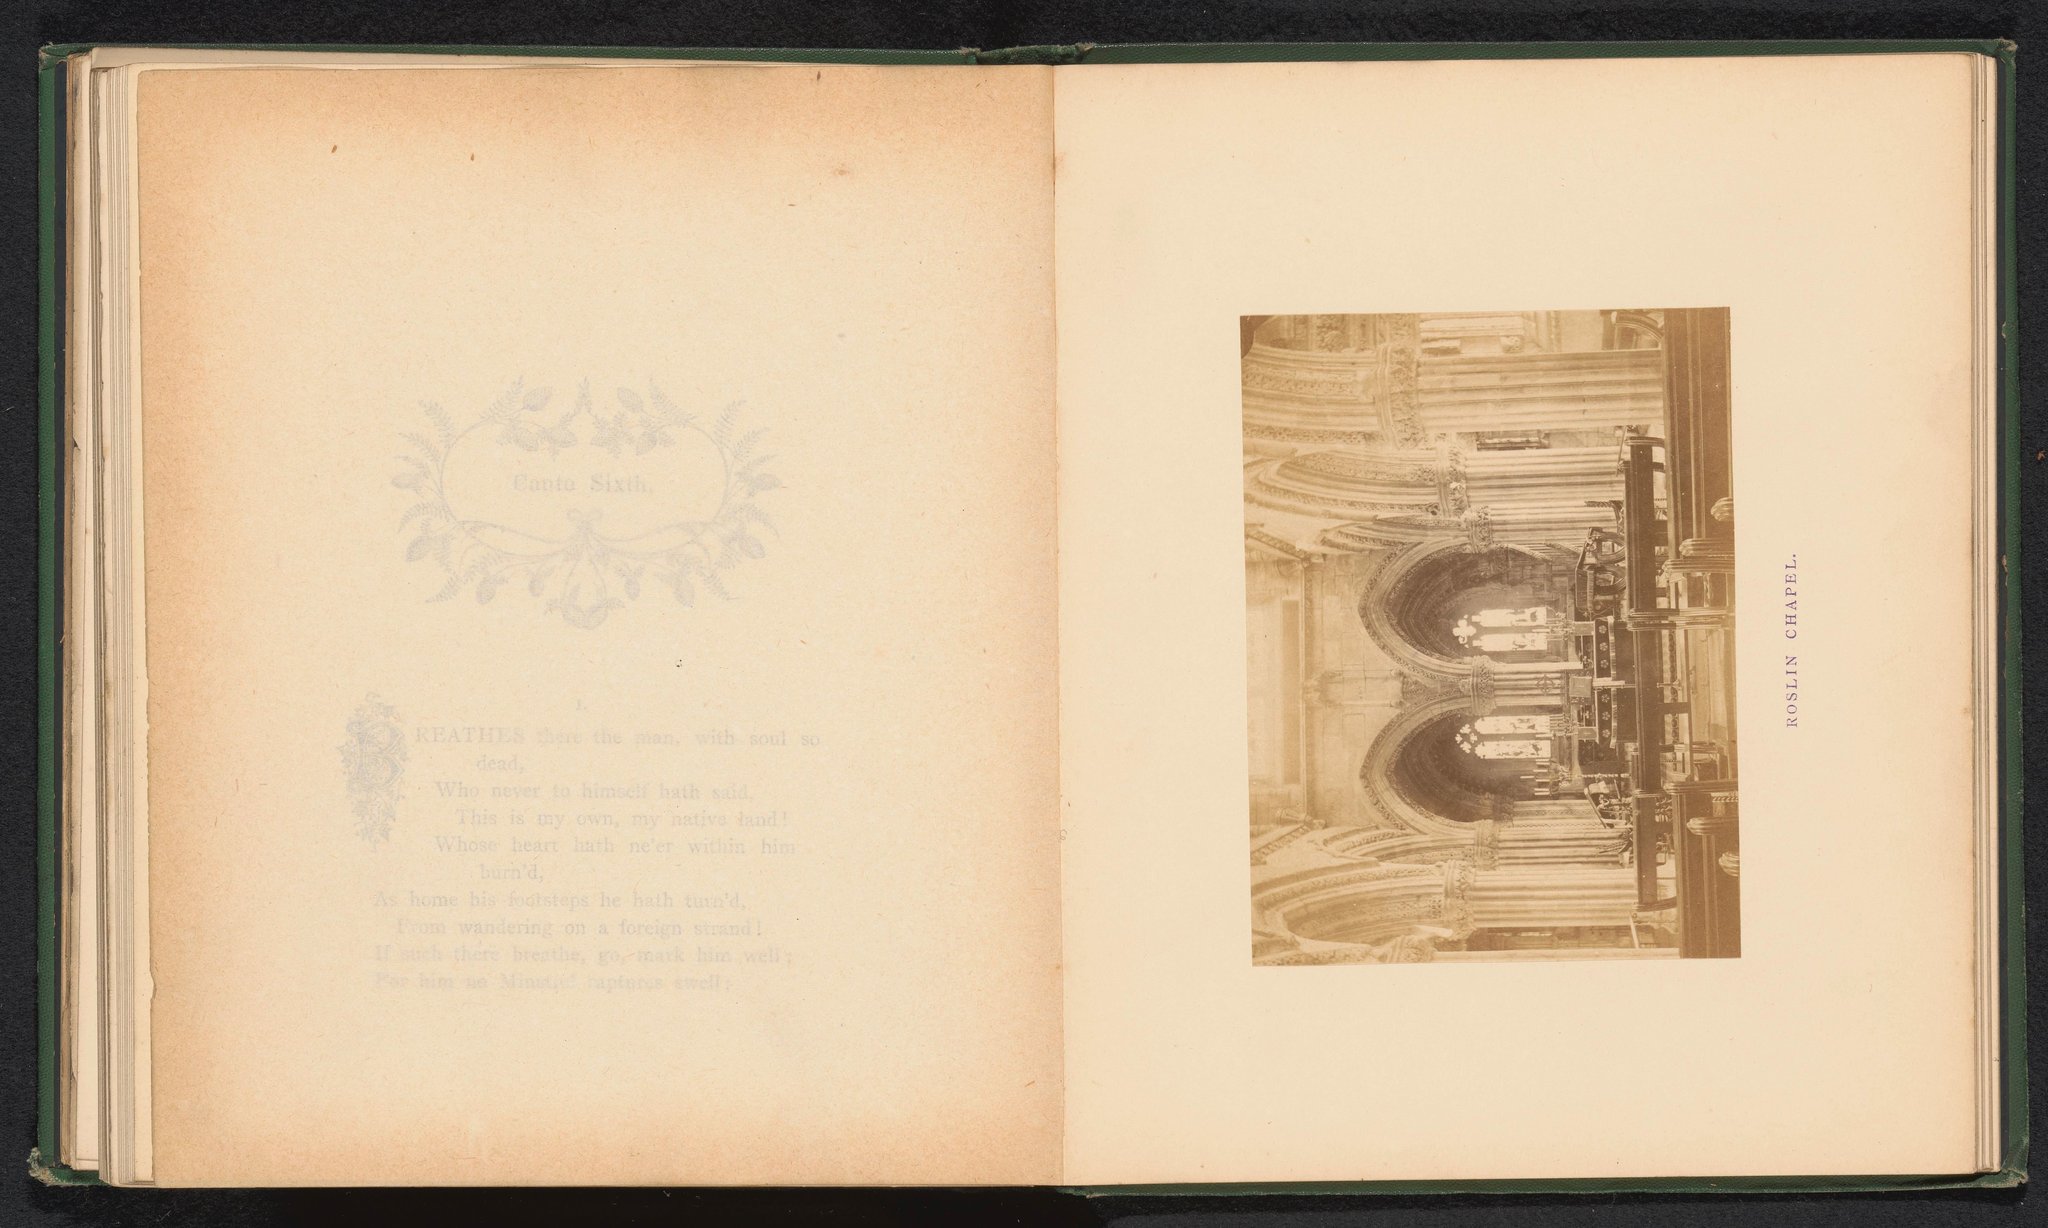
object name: page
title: Roslin Chapel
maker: william russell sedgfield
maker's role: fotograaf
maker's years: 1826-1902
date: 1862-1872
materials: photographic support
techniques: albumen print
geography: rosslyn chapel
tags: interior of church